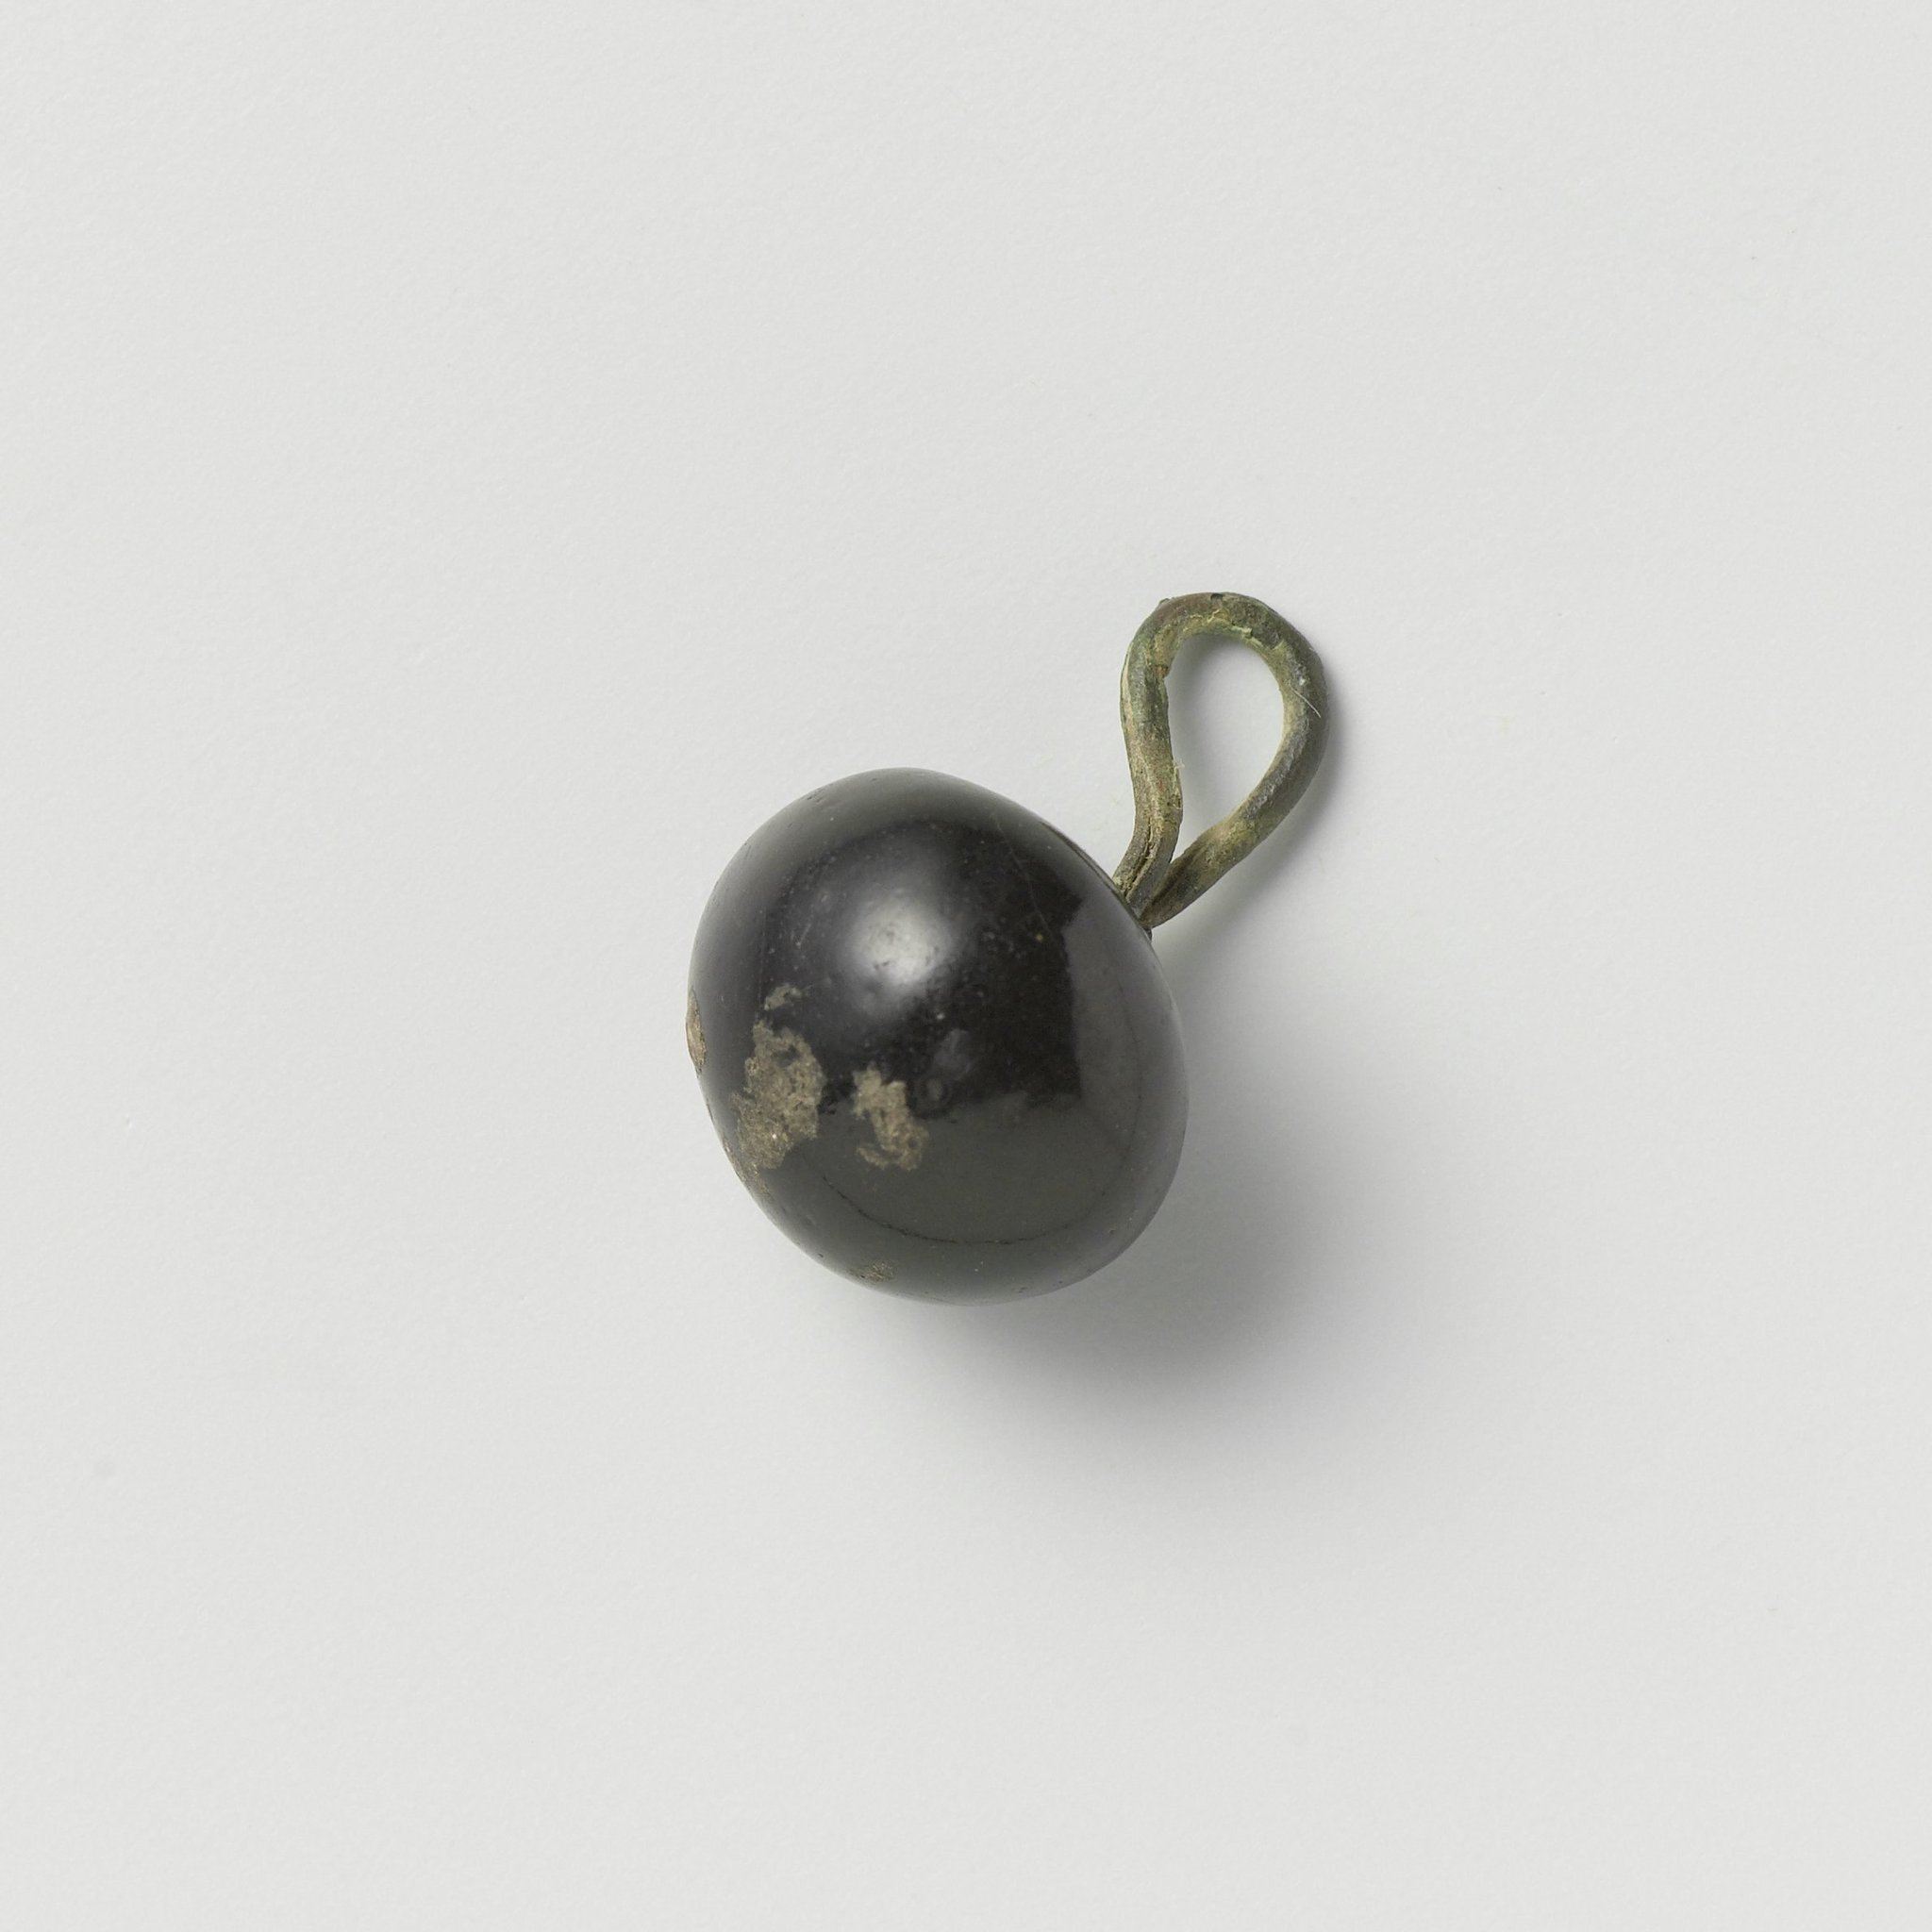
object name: button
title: Knoop bestaande uit een ronde bol met koperen draadoog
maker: Anonymous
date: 1590-1596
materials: copper, glass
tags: willem barendsz., amsterdam, jacob van heemskerck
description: Knoop bestaande uit een ronde bol met koperen draadoog. Aan de knoop zitten textielresten.